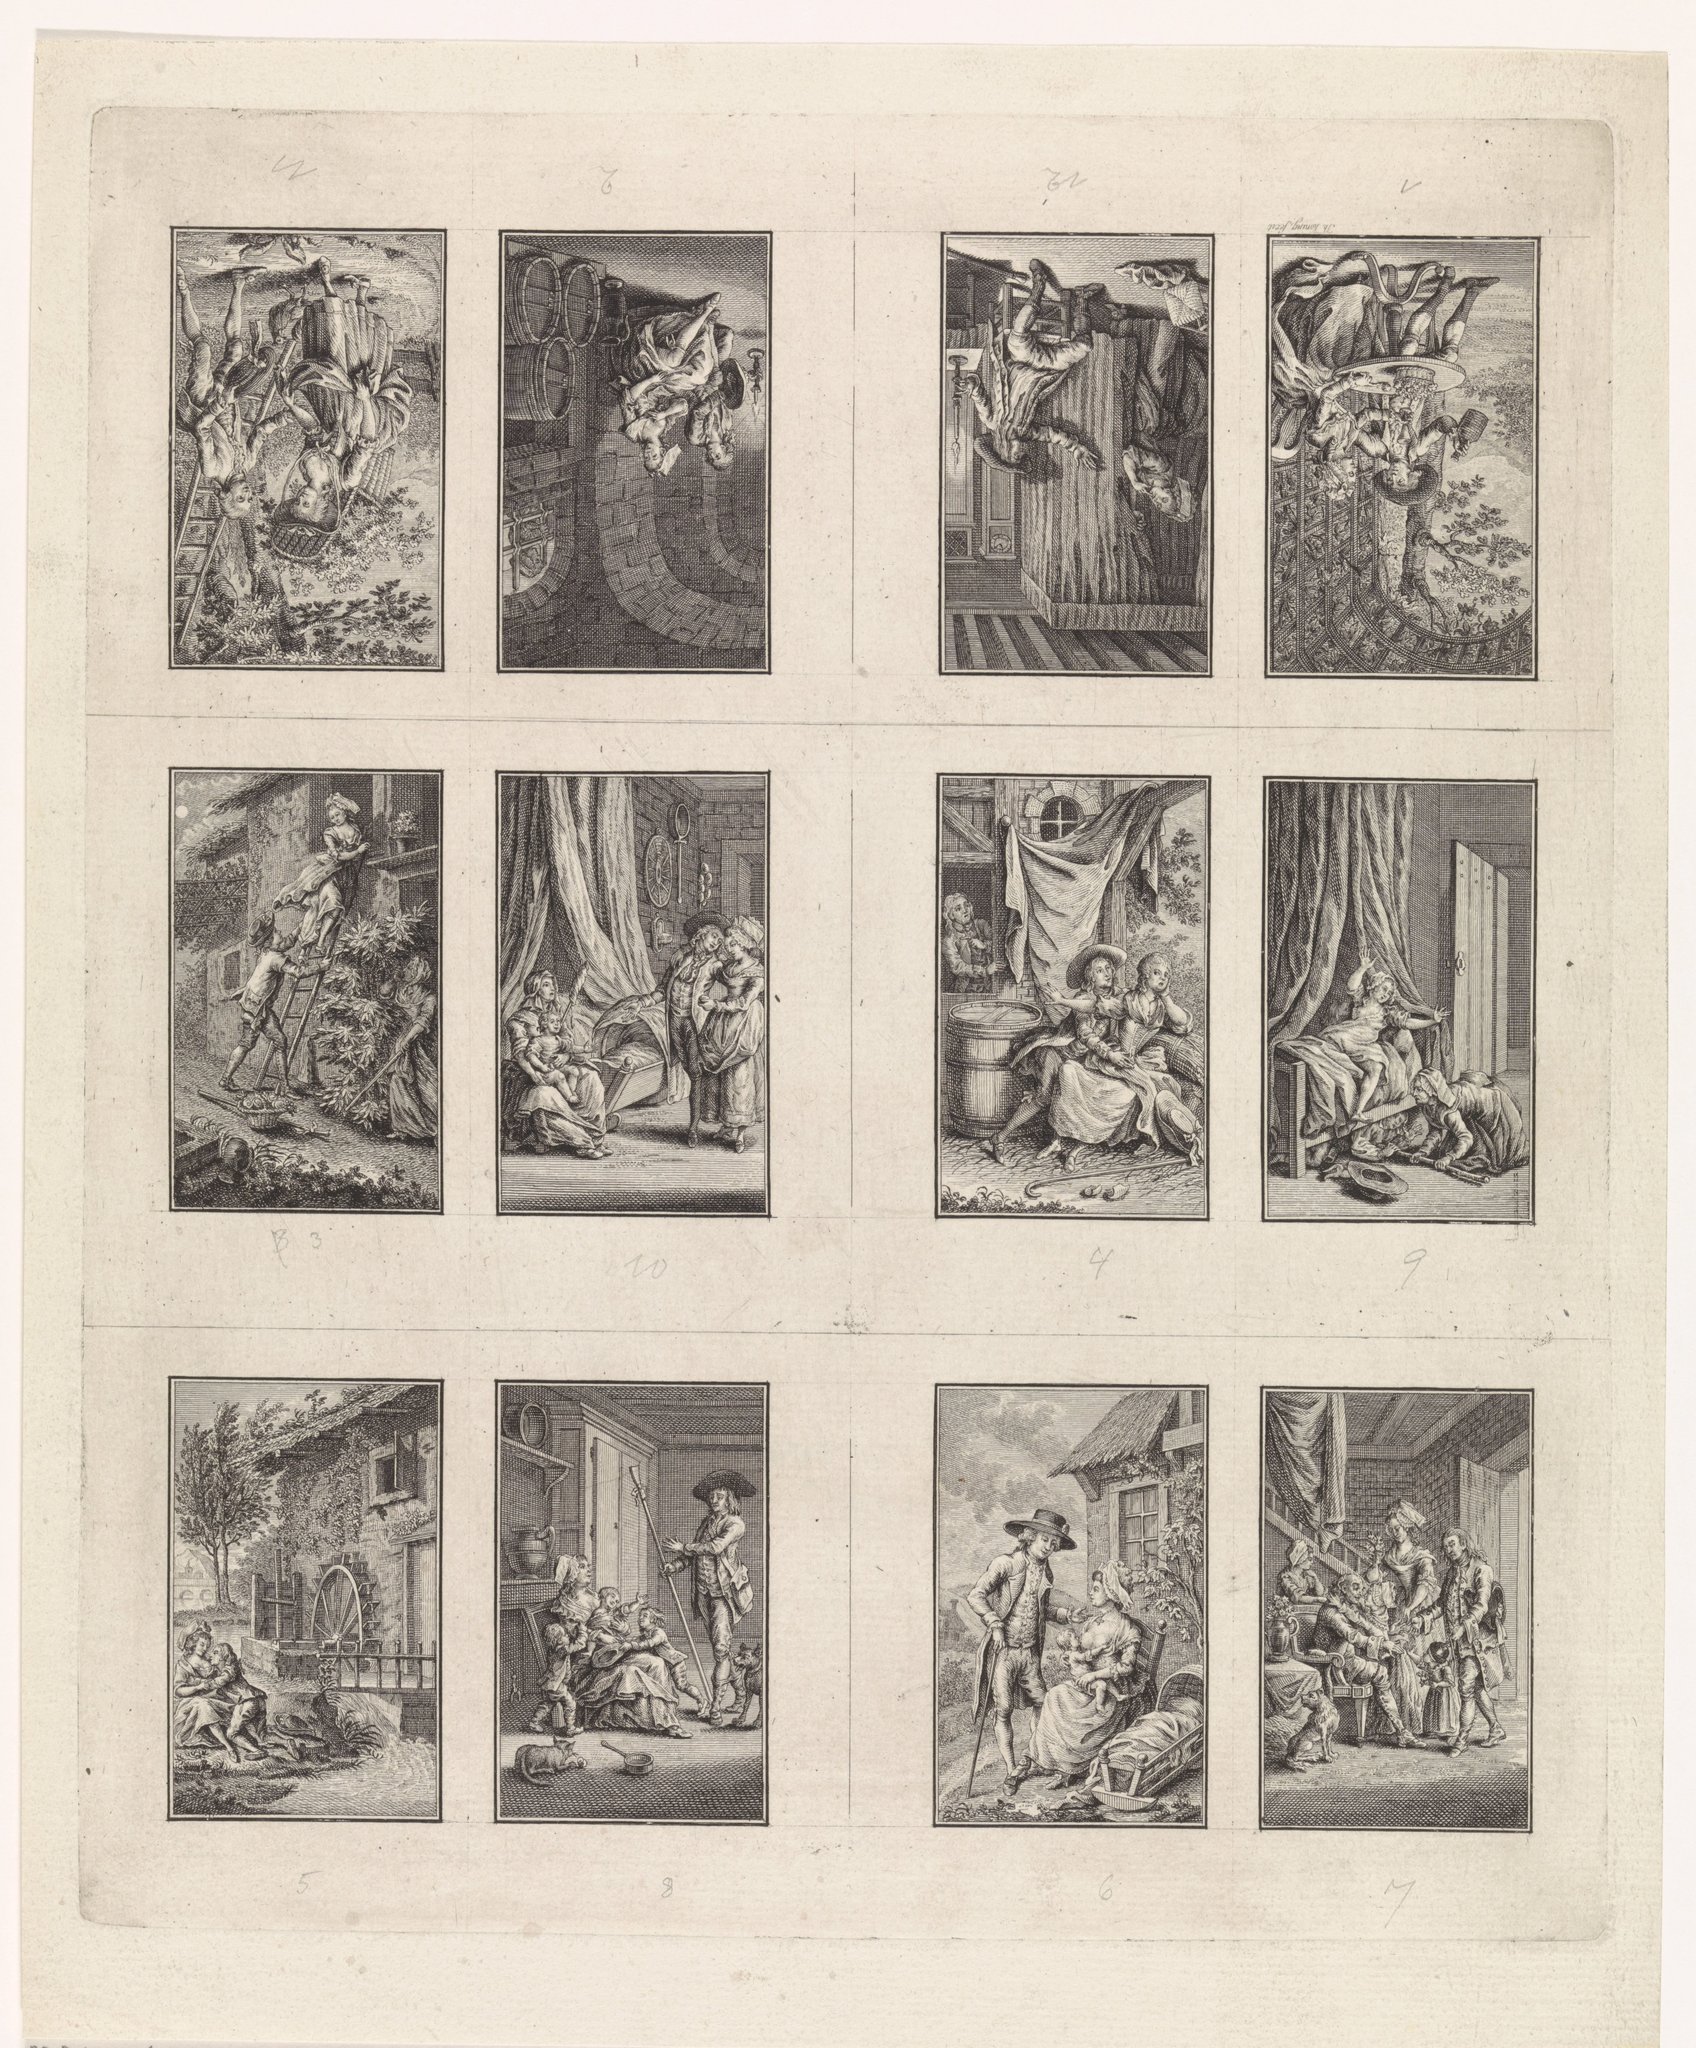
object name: print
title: Twaalf voorstellingen over geliefdes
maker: theodoor koning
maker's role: print maker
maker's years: 1748-1829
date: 1758-1829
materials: paper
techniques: engraving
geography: amsterdam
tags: hiding, hiding oneself, couple of lovers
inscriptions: collector's mark: Lugt 2228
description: Niet versneden blad met twaalf kluchtige voorstellingen over geliefdes, mogelijk uit een theaterstuk. De afbeeldingen zijn middenonder in potlood genummerd van 1 tot en met 12.